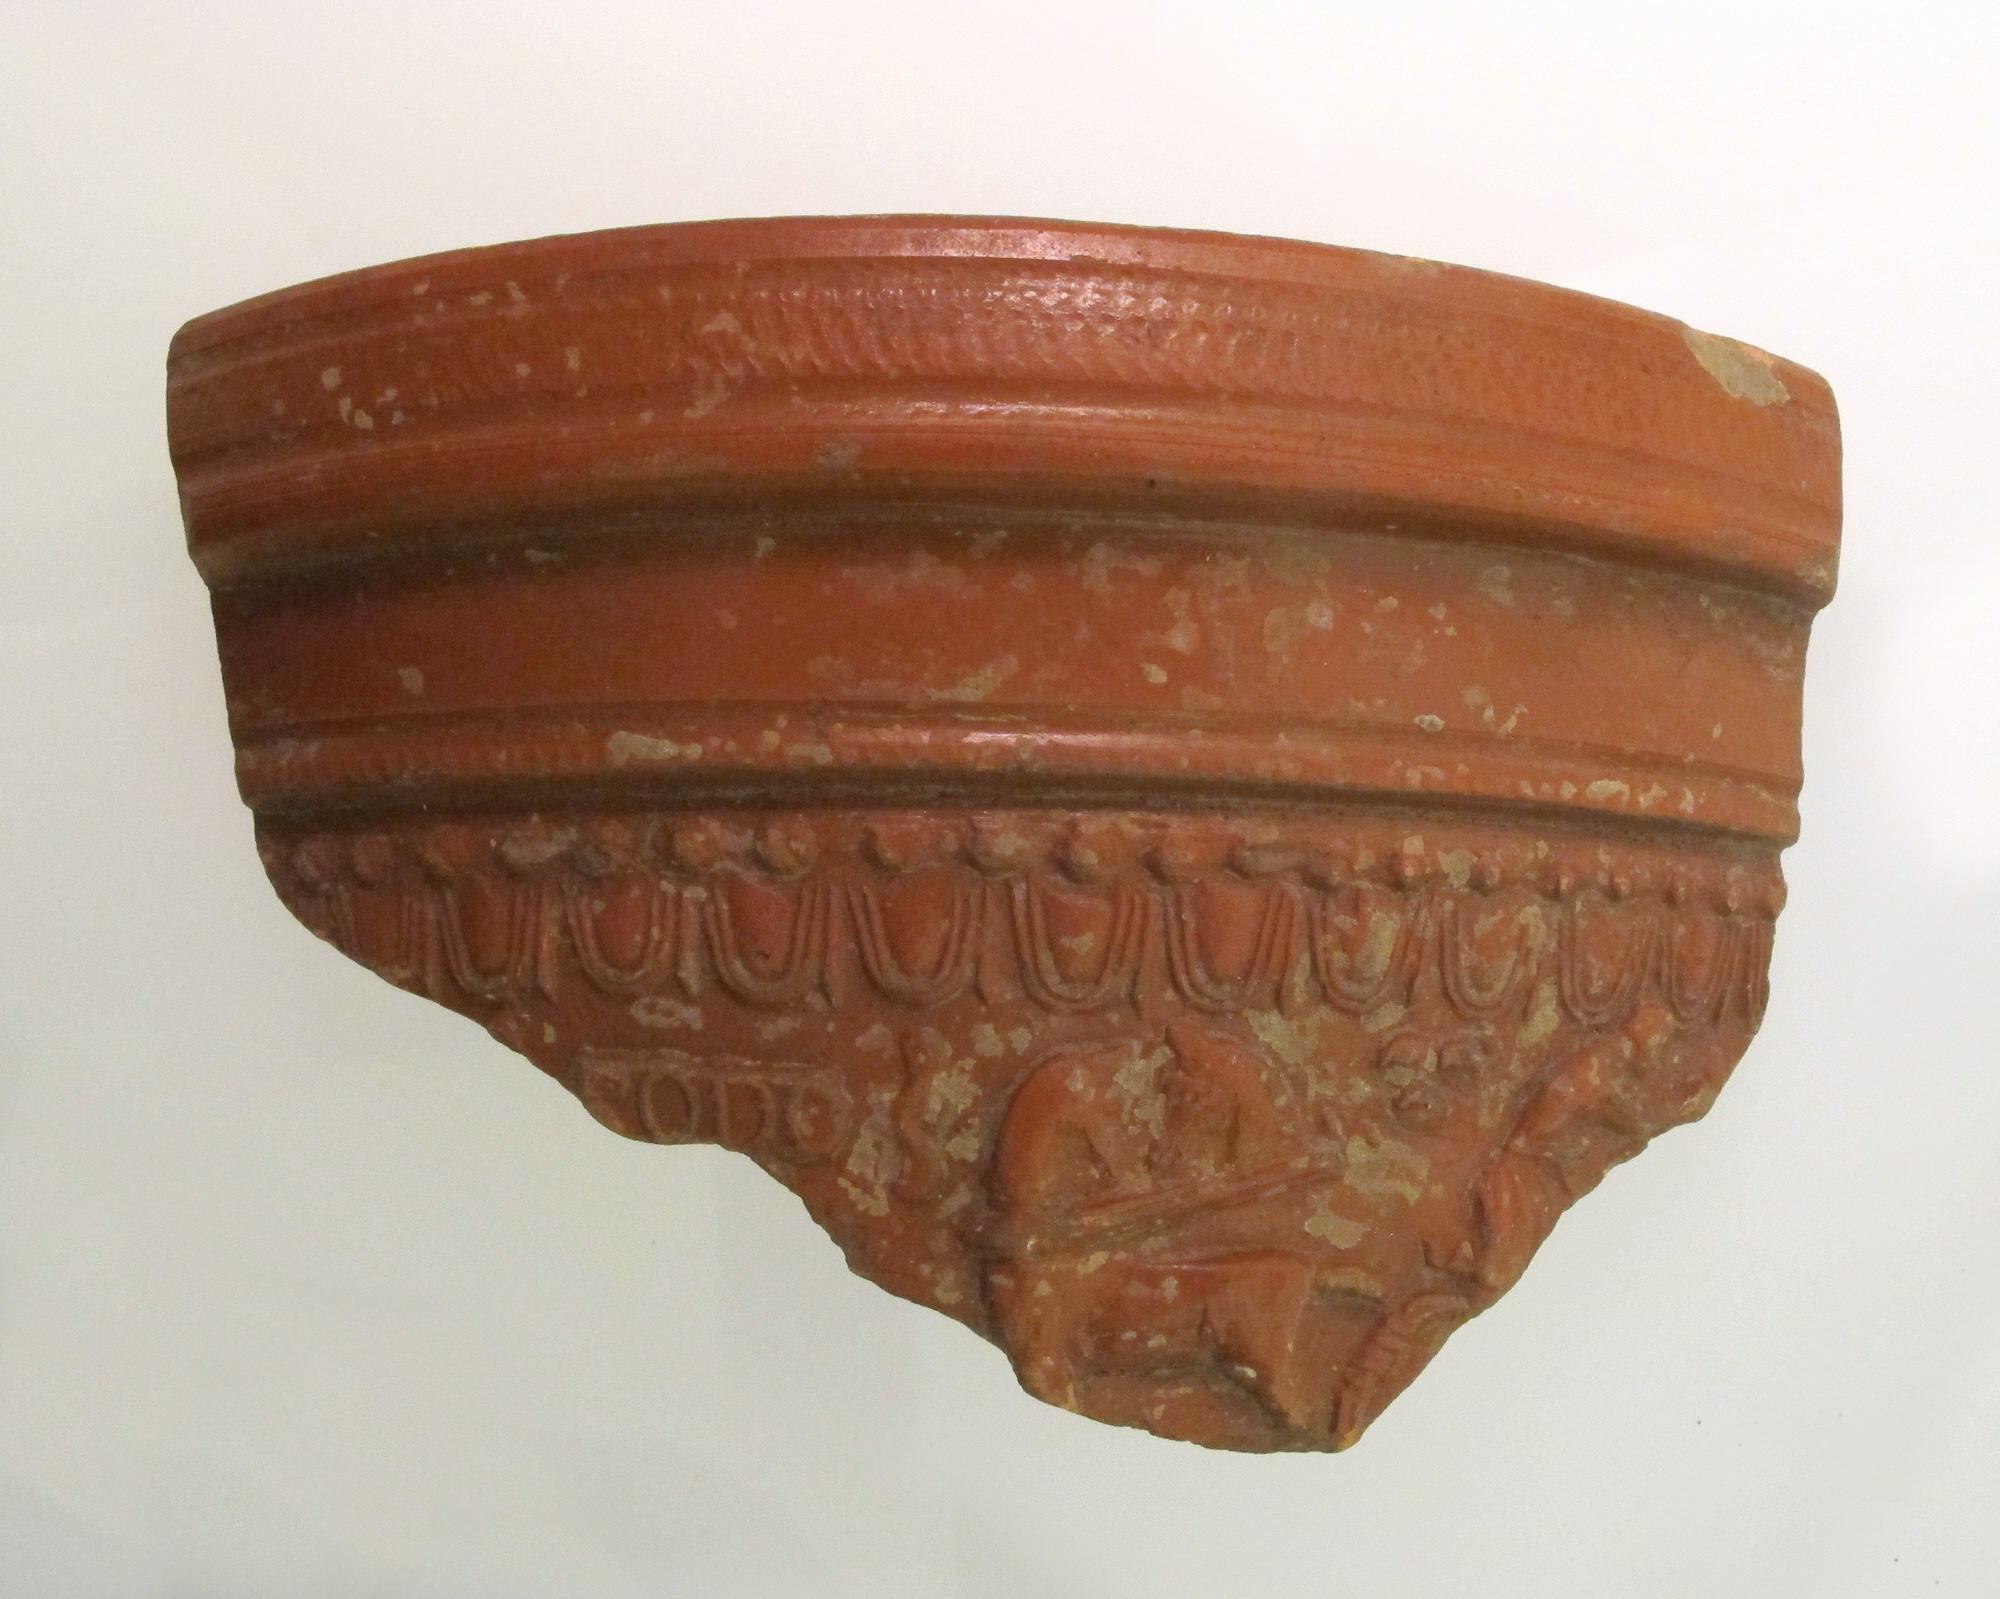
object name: vase fragment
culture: roman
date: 100 BCE-100 CE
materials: terracotta